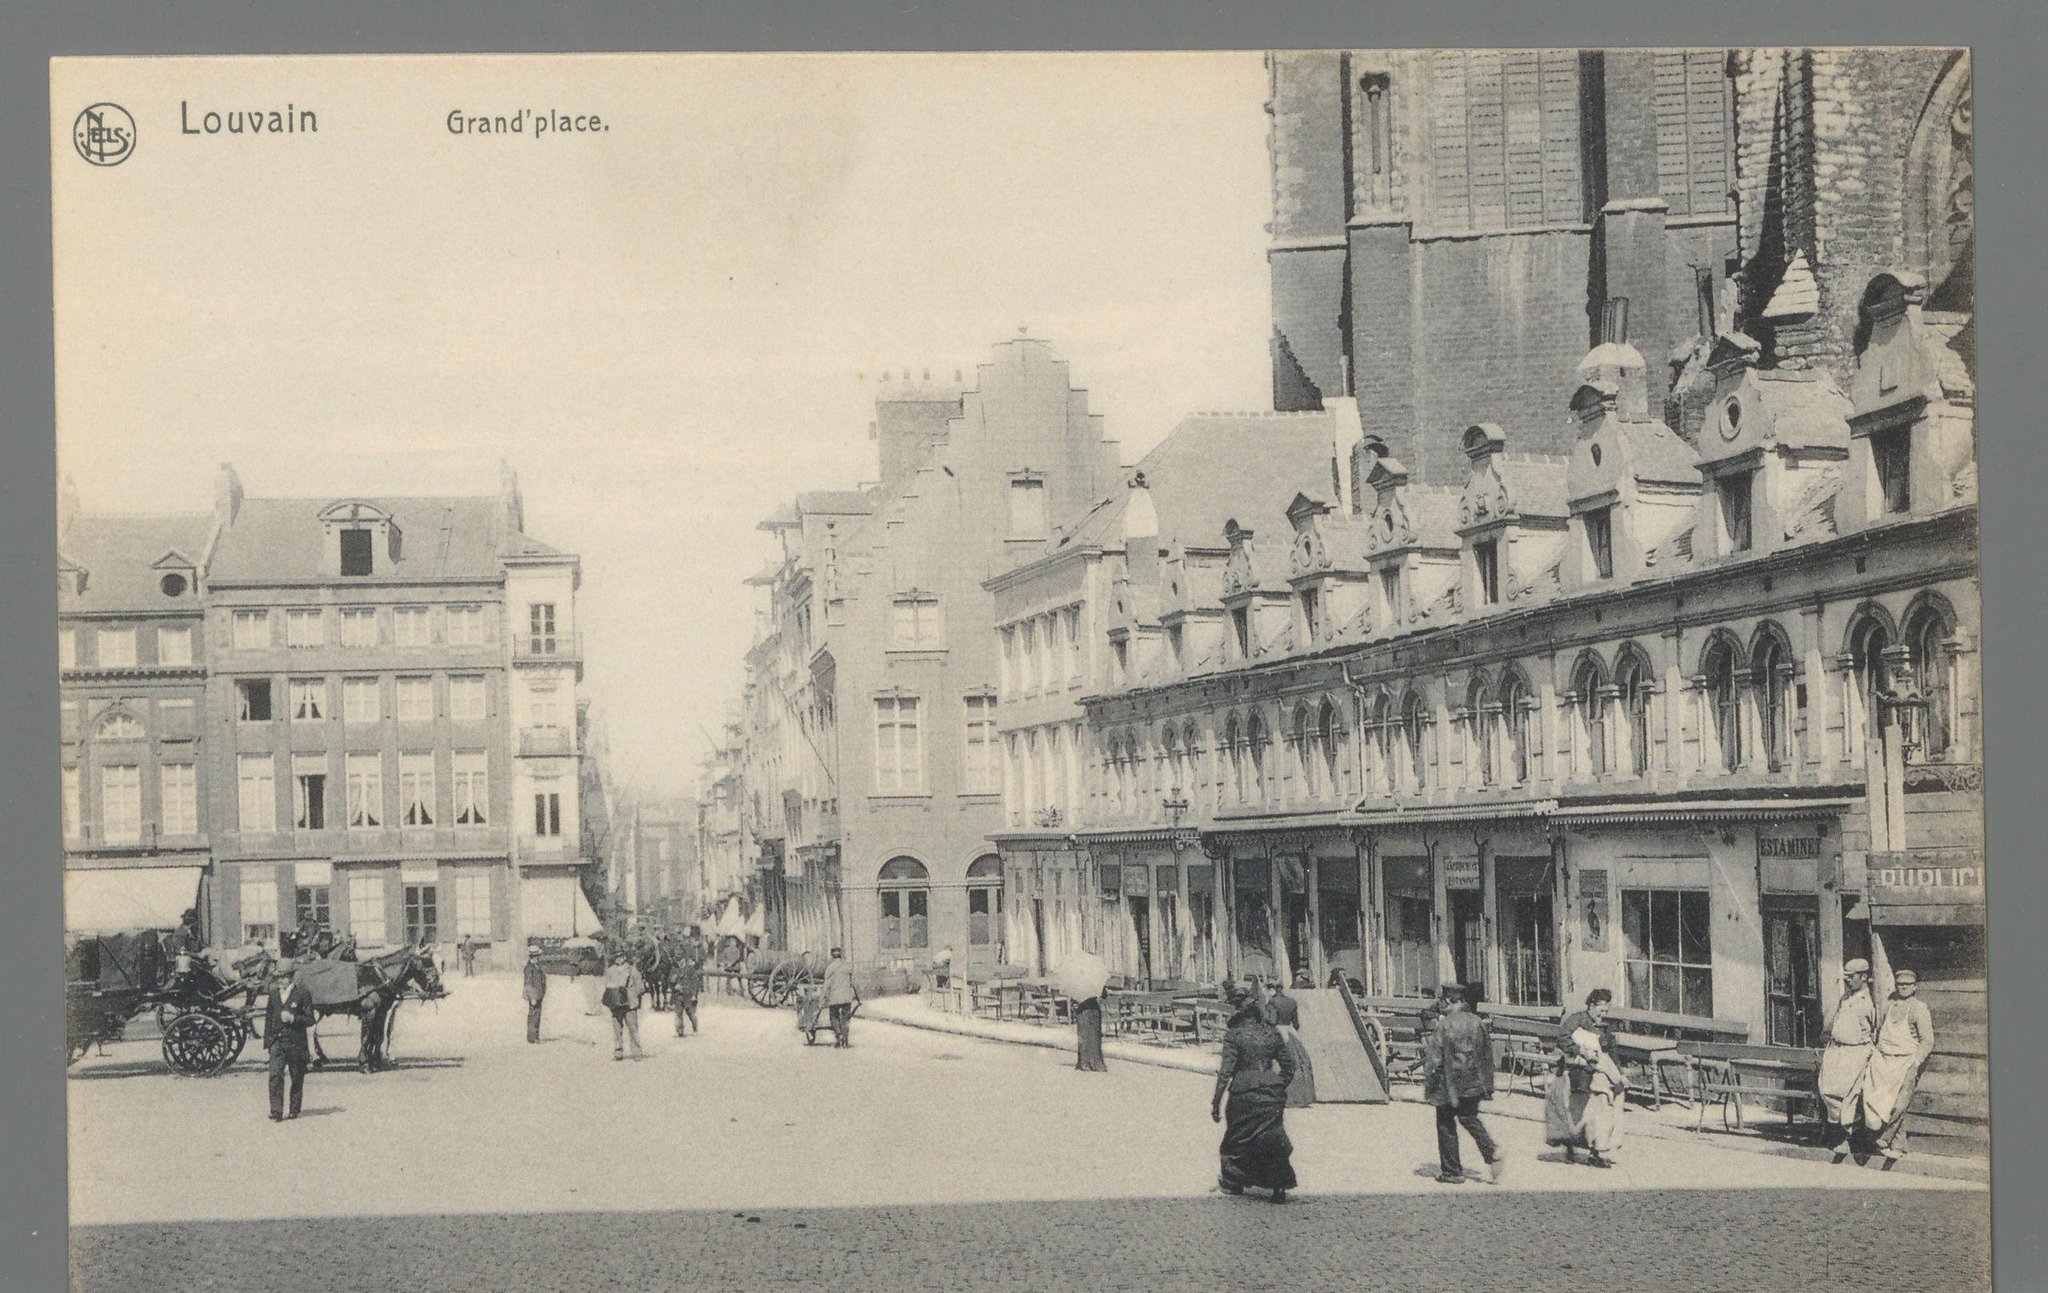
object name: ansichtkaart, prentbriefkaart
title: Serie Louvain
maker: Anonymous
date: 1907-1913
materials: cardboard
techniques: photograph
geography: leuven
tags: square, place, circus, etc. (+ city(-scape) with figures, staffage), louvain